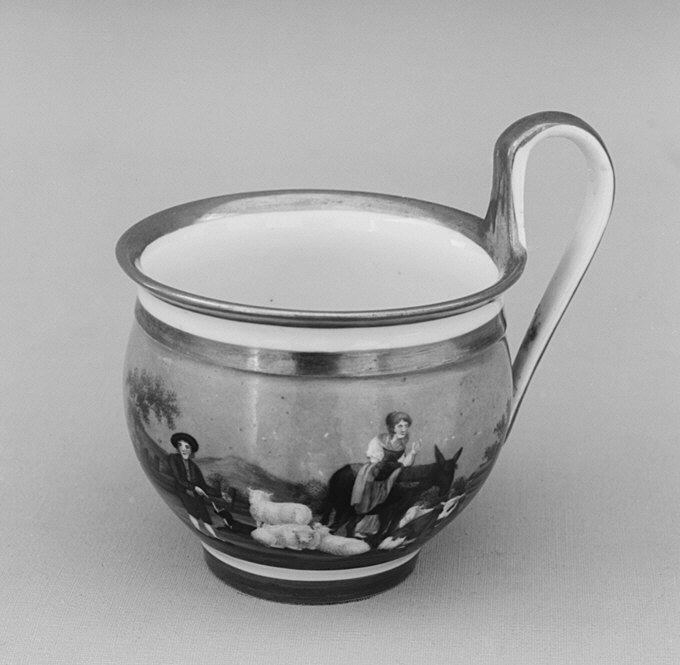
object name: cup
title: Cup (one of six) (part of a set)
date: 1820-1830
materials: hard paste porcelain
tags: men,women,horses,sheep